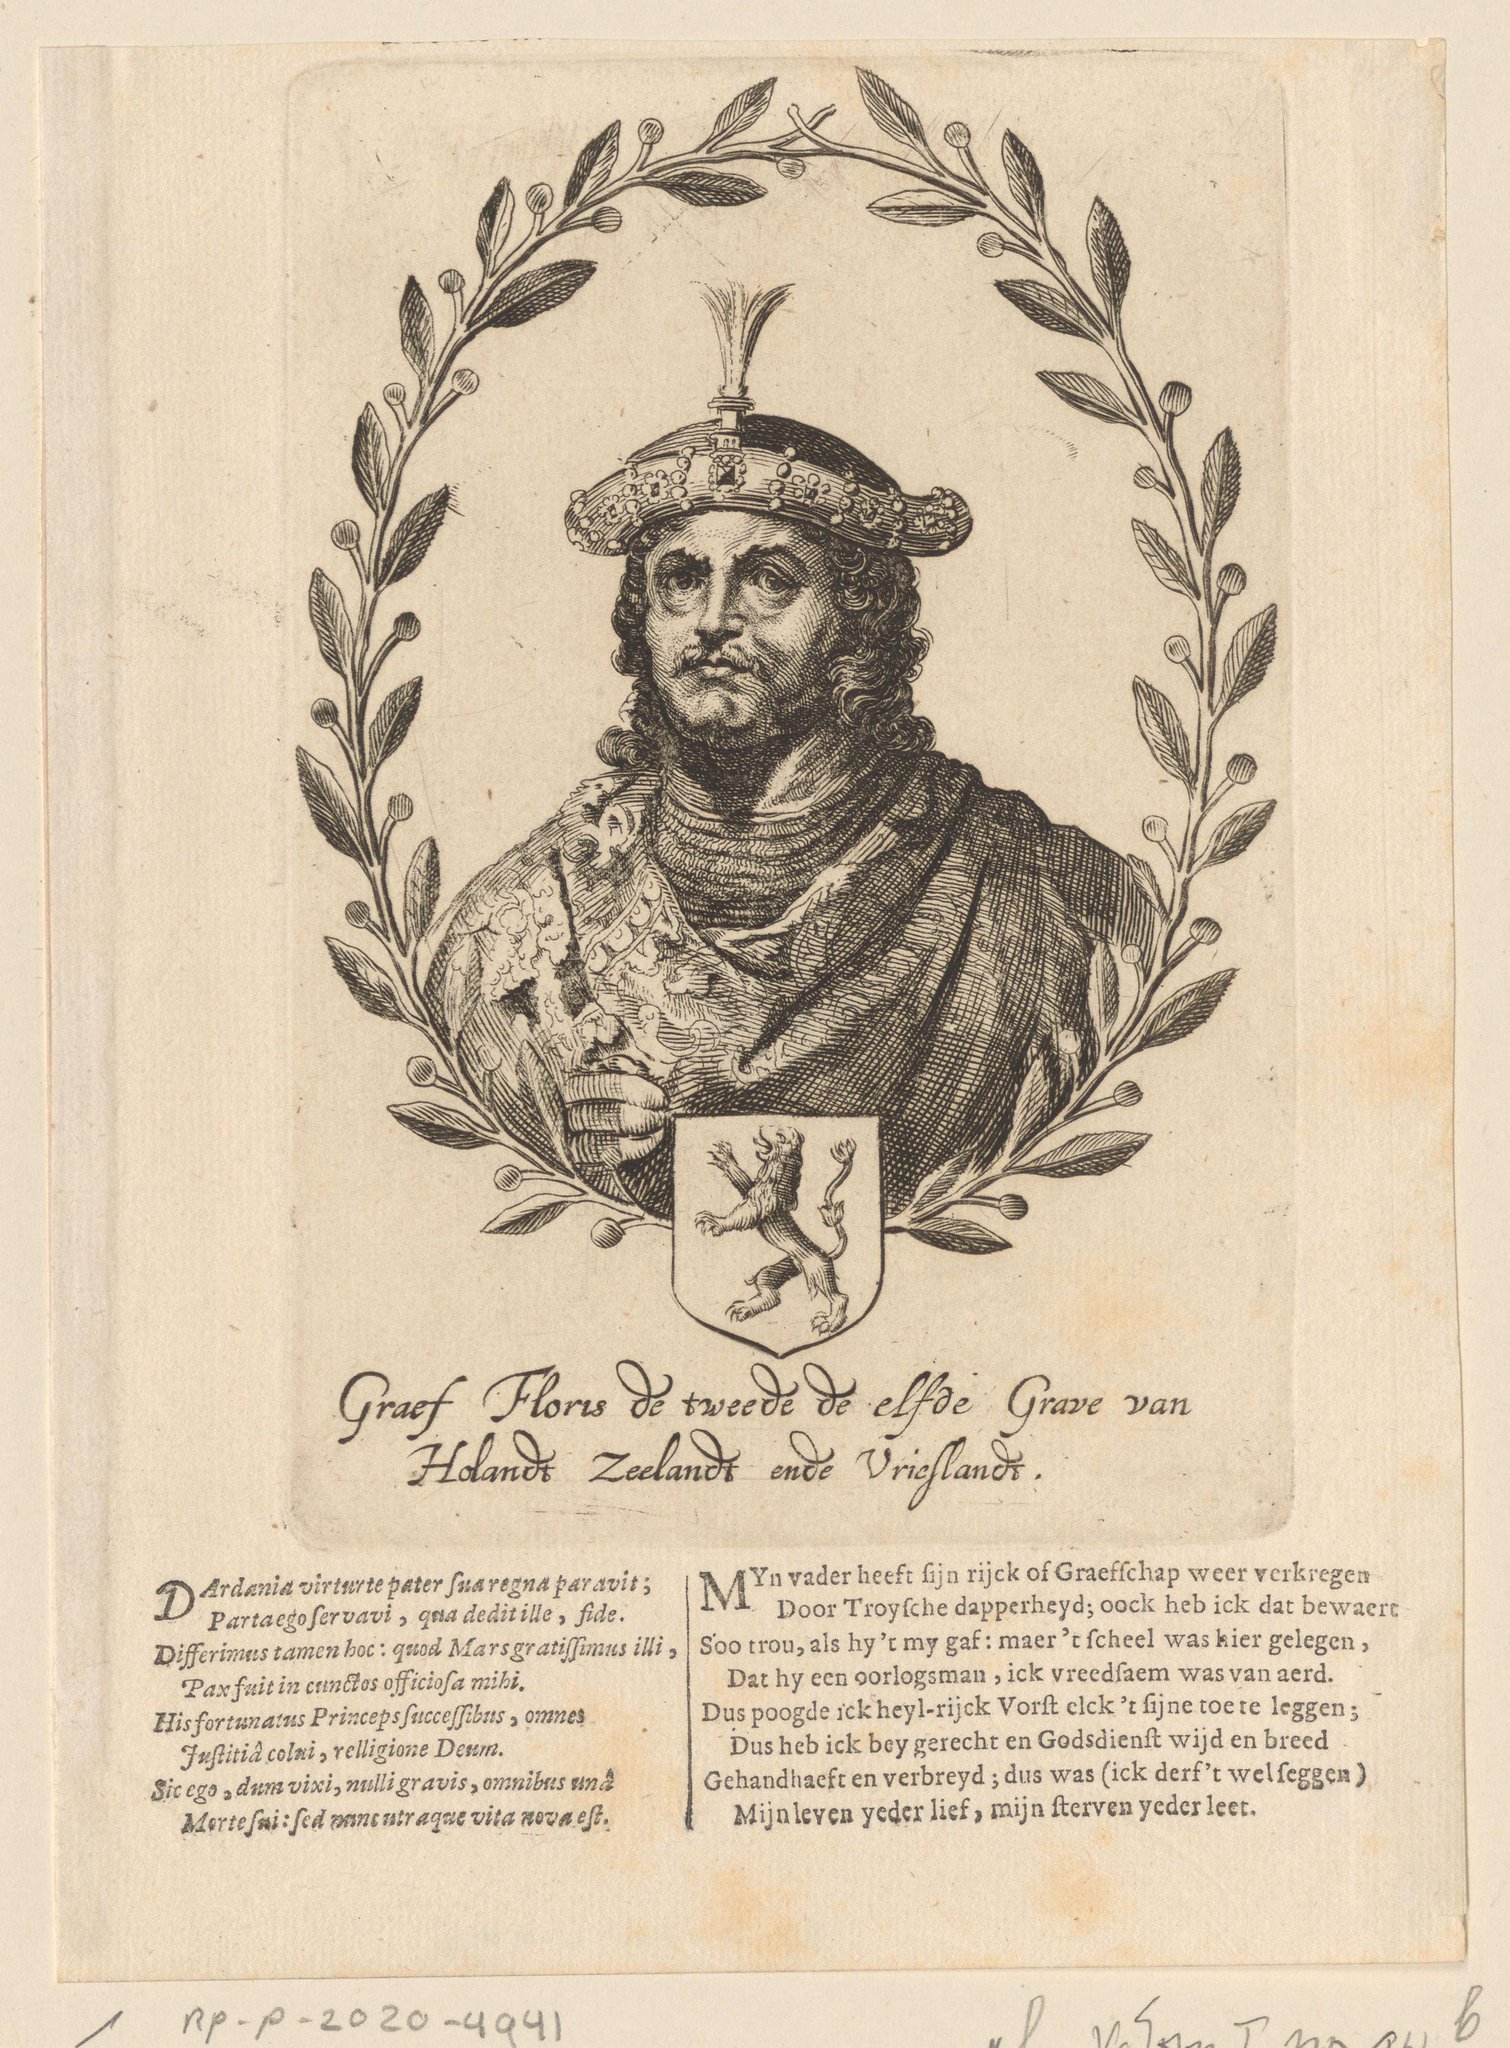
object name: print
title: Portret van Floris II, graaf van Holland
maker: Anonymous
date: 1678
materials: paper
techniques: engraving, etching, letterpress printing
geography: northern netherlands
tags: floris ii (count of holland), historical persons, armorial bearing, heraldry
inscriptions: collector's mark: Lugt 964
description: Prent waarschijnlijk uit: Scriverius, Petrus. Hollandsche, Zeelandsche ende Vriesche Chronyck (...). Den Haag: Johann Veely en Jasper Doll, 1678, p. 117. Eerdere staat gebruikt in 'Oude Hollandsche Geschiedenissen (...)' van Wachtendorp, 1645.